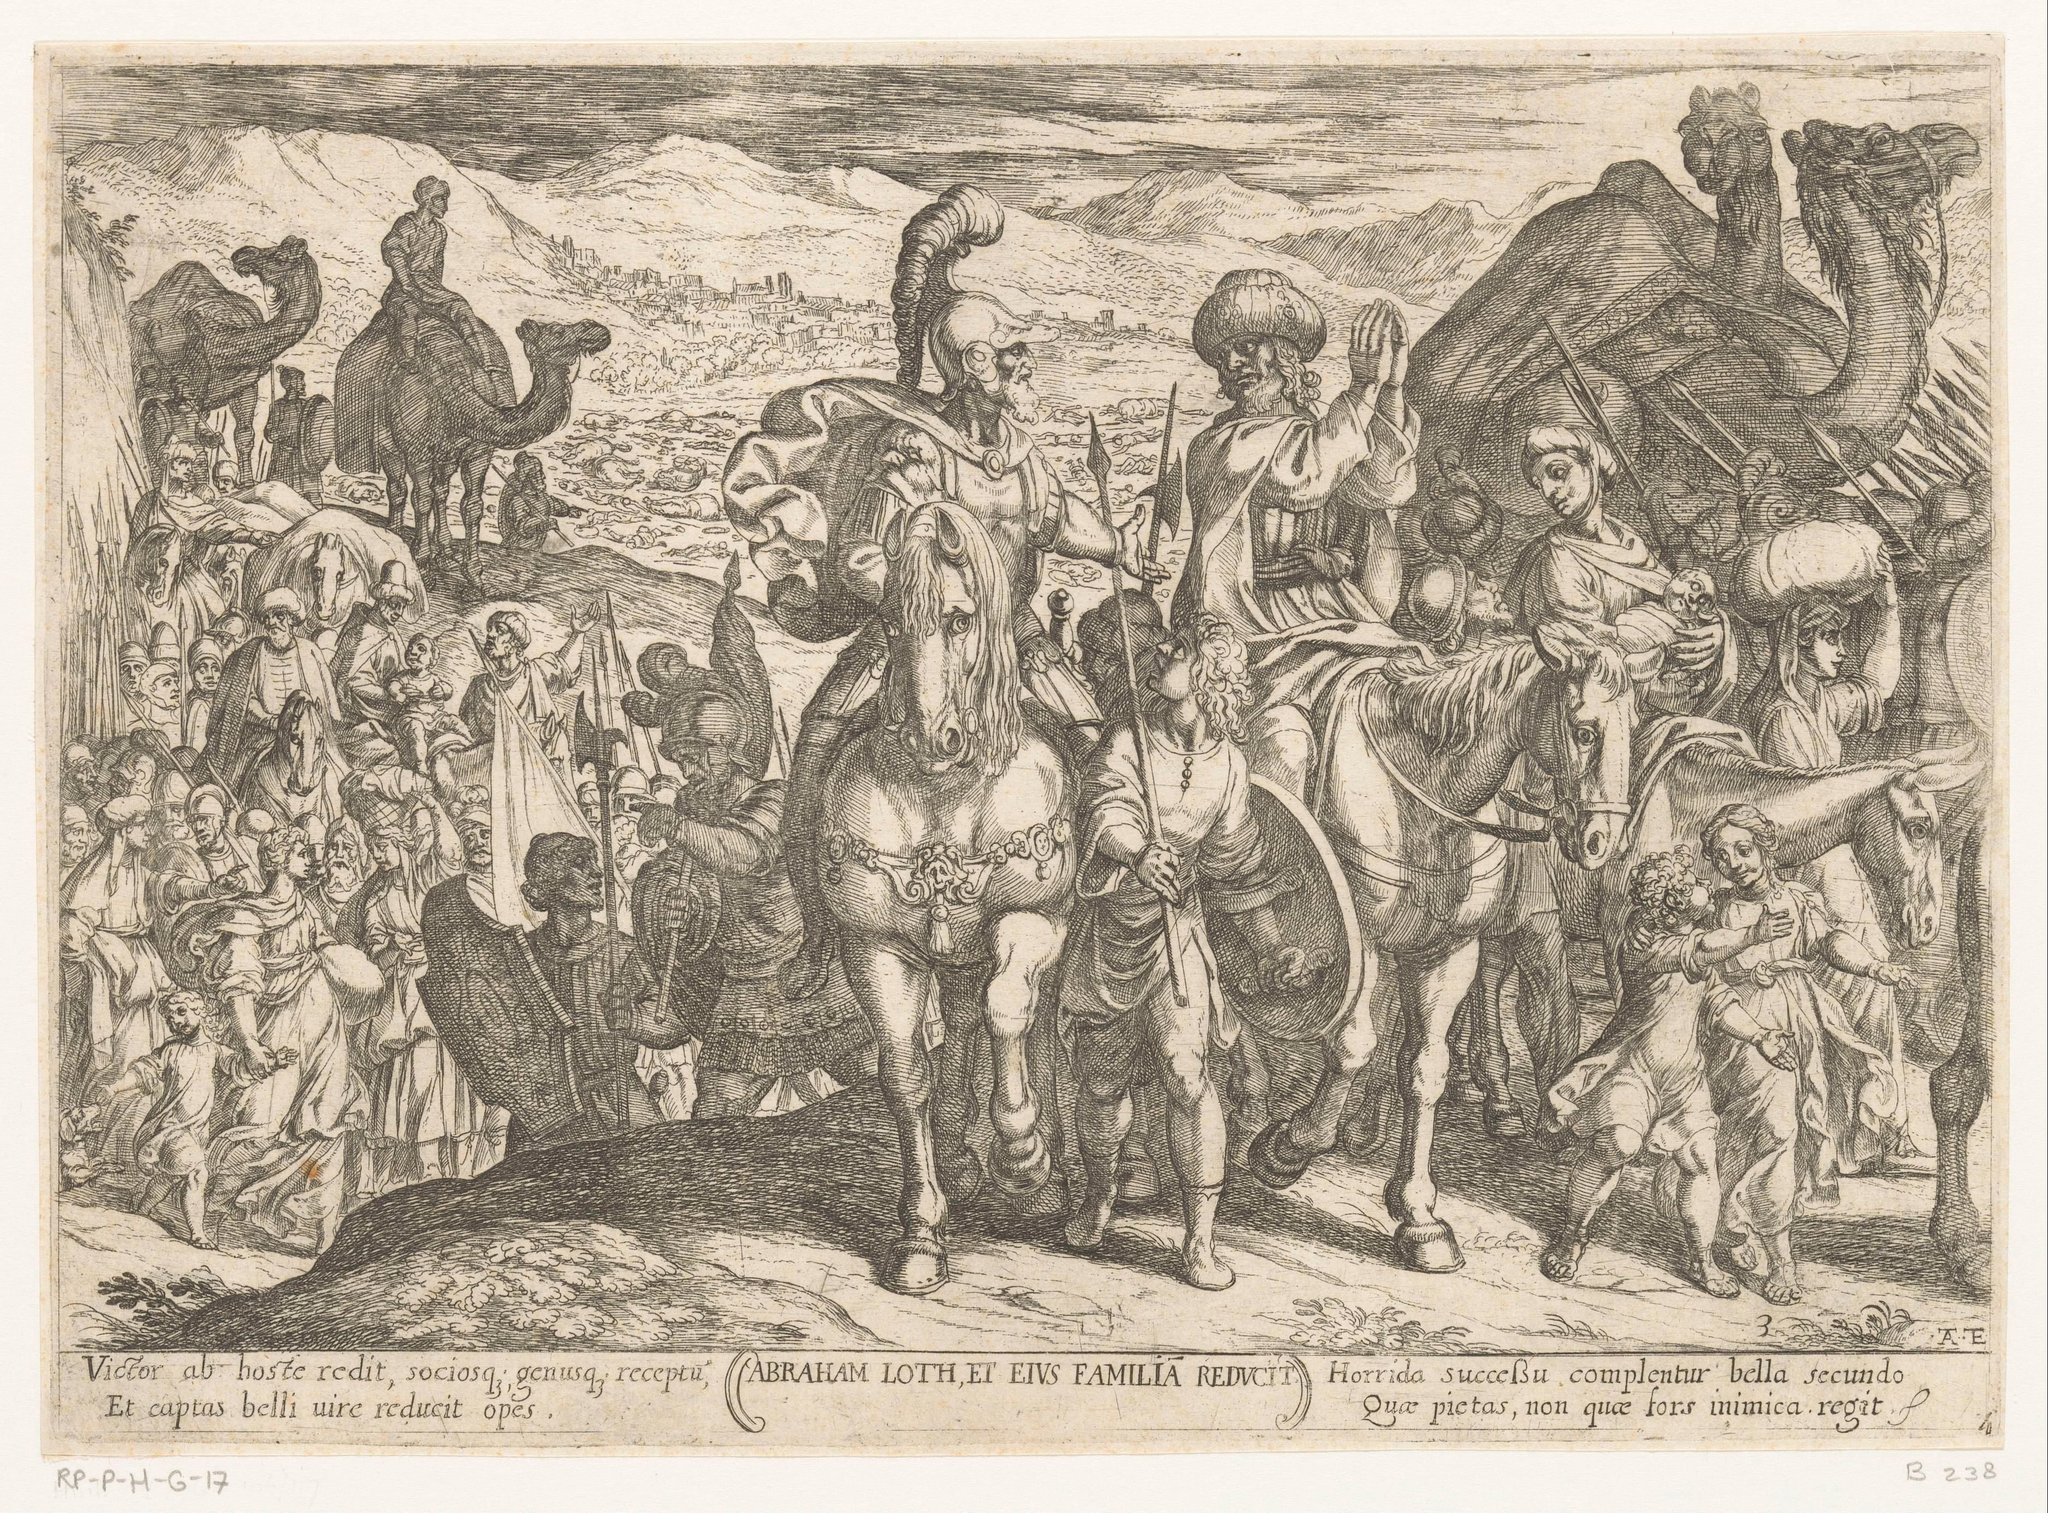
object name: print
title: Abraham brengt Lot en zijn familie naar zijn eigen land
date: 1613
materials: paper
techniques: etching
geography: italy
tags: abraham liberates lot, recovers the stolen goods and returns in triumph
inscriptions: number: ‘4’, collector's mark: ‘Hinloopen’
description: Abraham en zijn leger brengen Lot en zijn bezittingen en vrouwen terug naar hun land. Titel en onderschrift in het Latijn in de ondermarge.